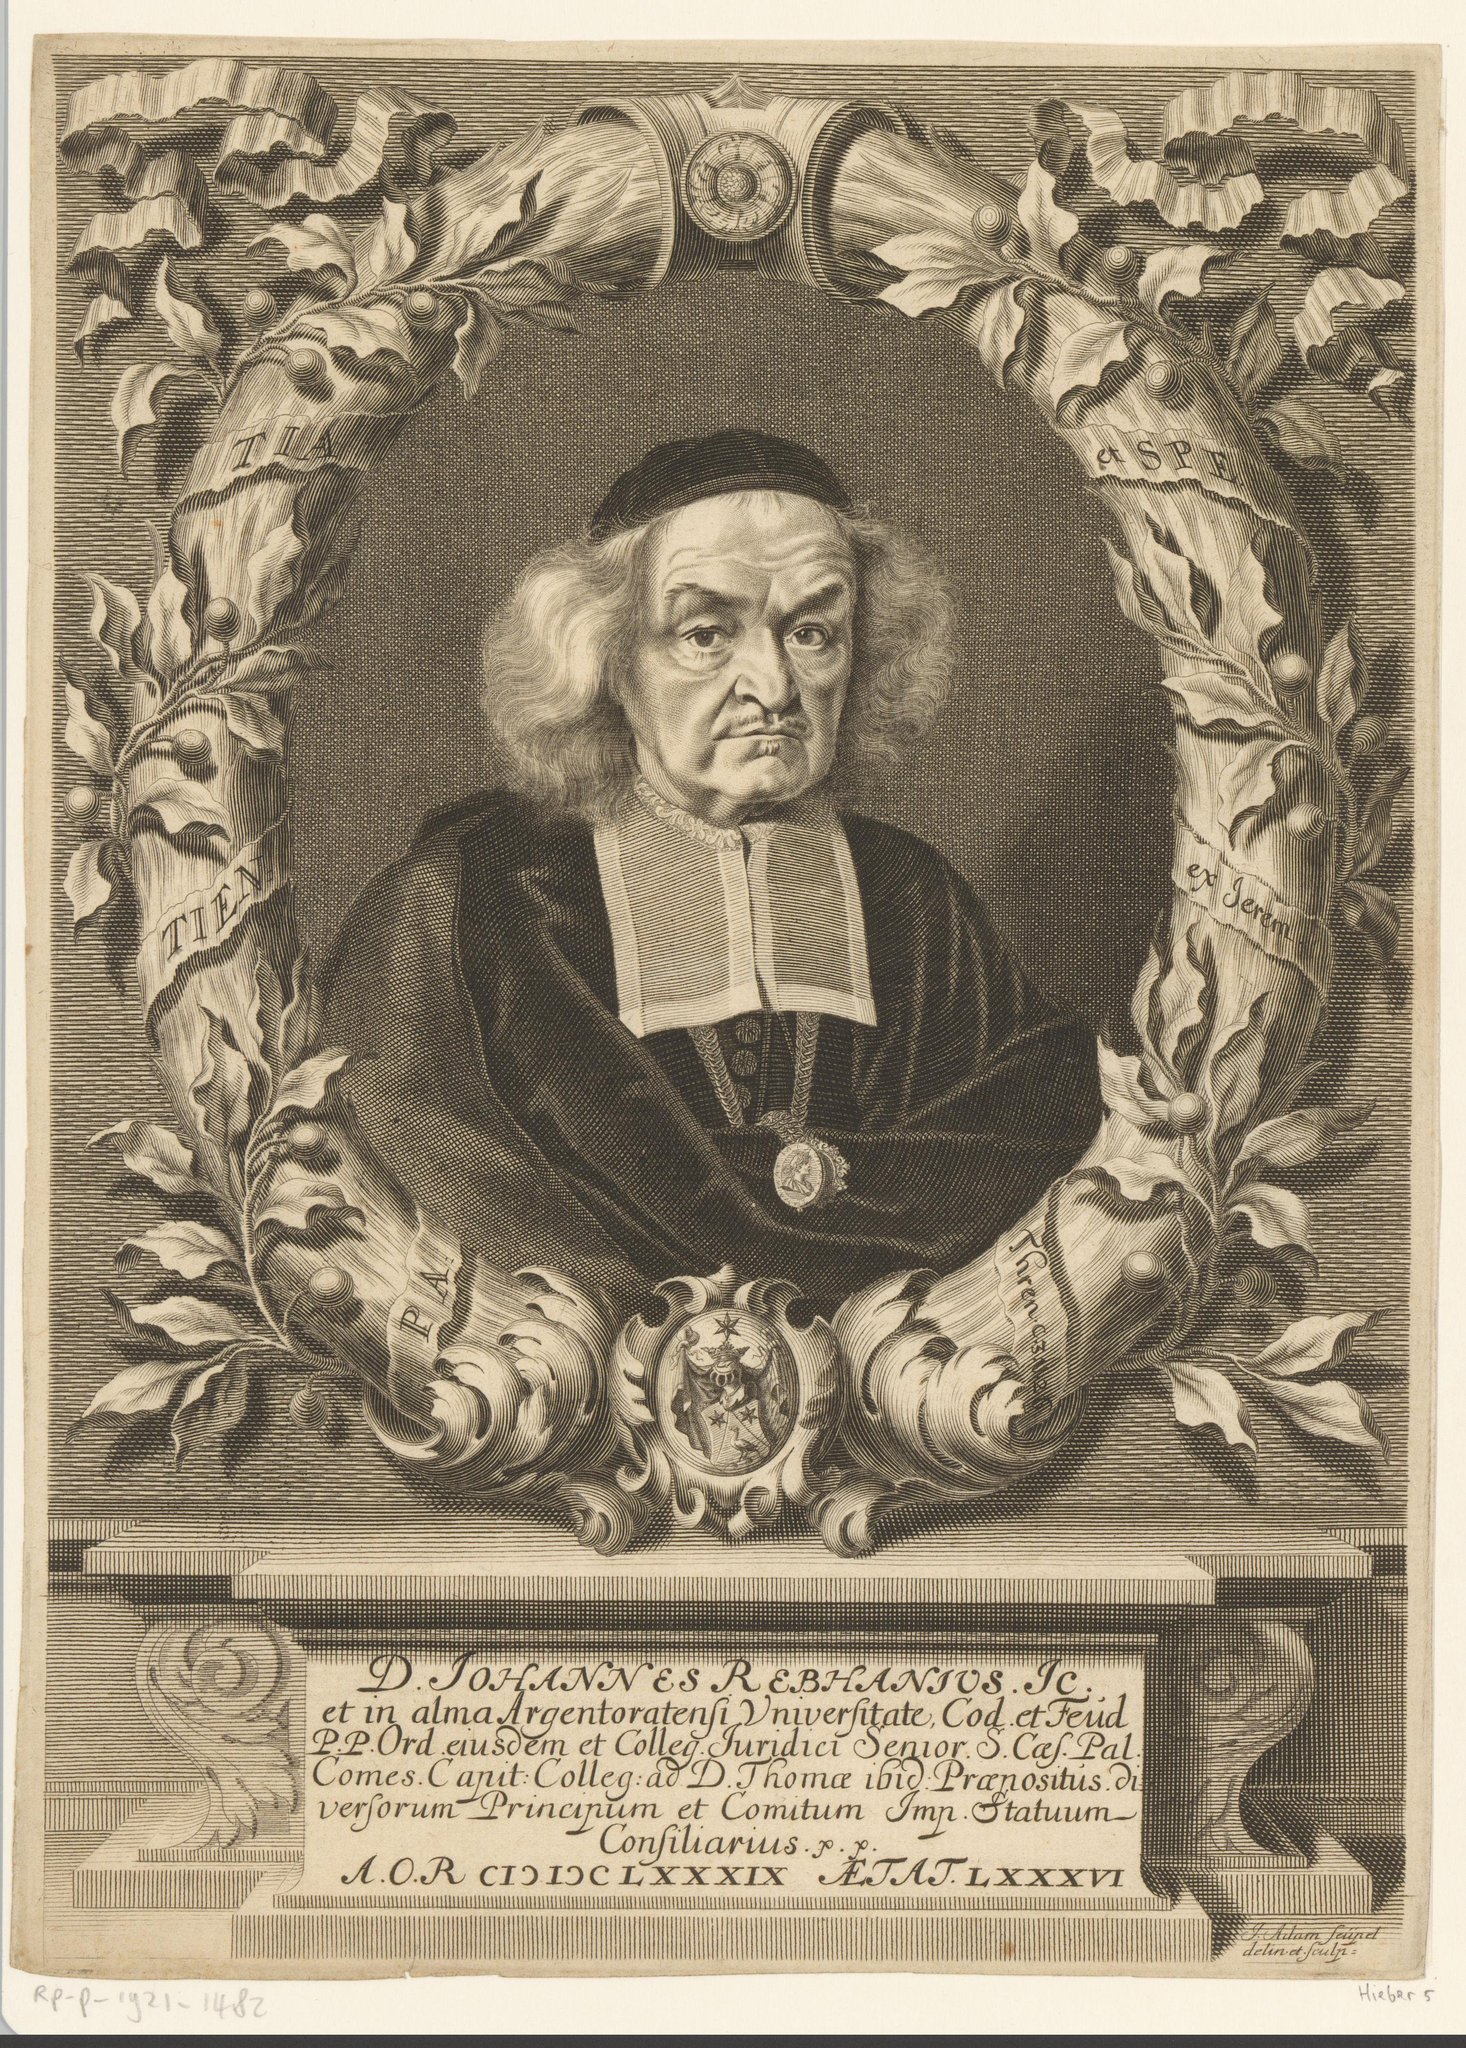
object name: print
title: Portret van Johannes Rebhan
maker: johann adam seupel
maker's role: painter, print maker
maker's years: 1662-1717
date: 1672-1717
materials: paper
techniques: engraving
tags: johannes rebhan, historical persons, pendant, trinket, 'breloque', armorial bearing, heraldry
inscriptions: collector's mark: Lugt 2228